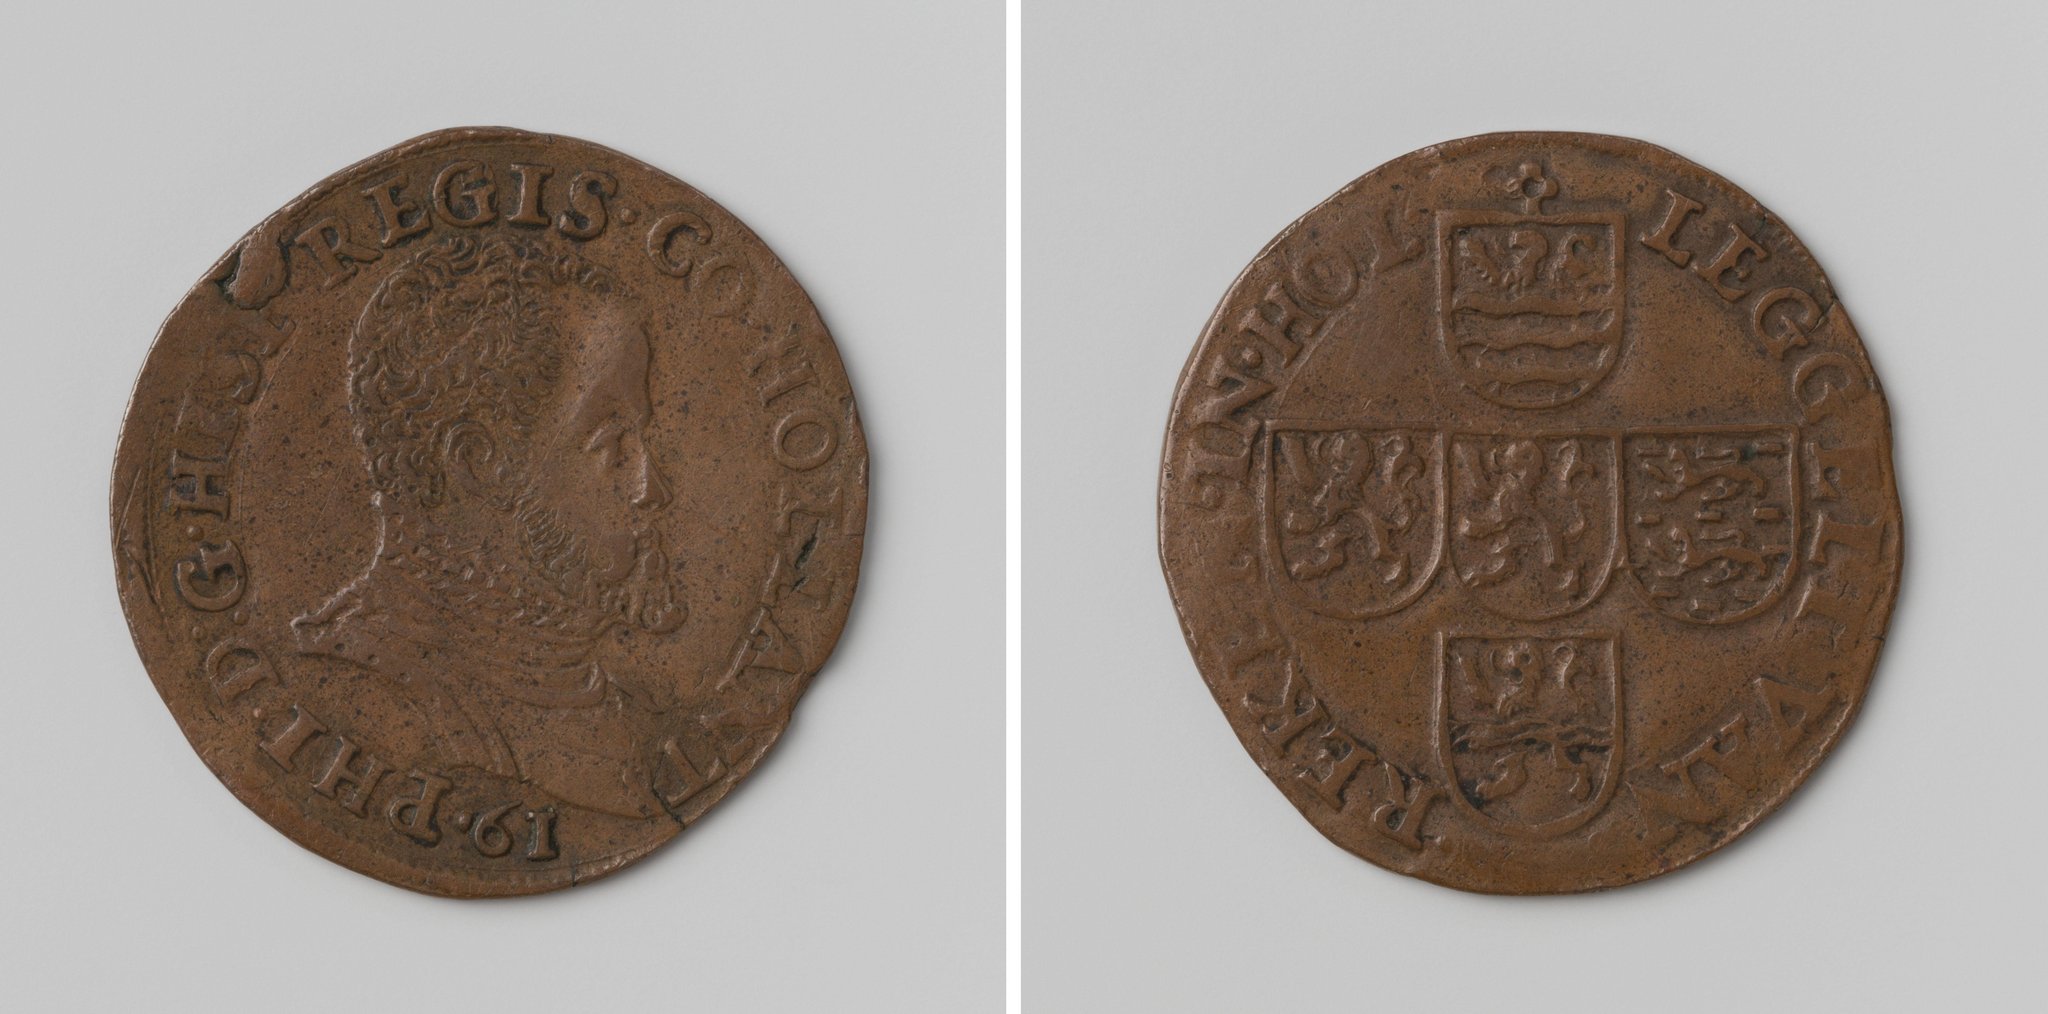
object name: jeton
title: Filips II, koning van Spanje, rekenpenning van de rekenkamer van Holland te 's-Gravenhage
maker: Anonymous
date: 1561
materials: copper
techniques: striking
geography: dordrecht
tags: philip ii of spain, the hague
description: Koperen penning. Voorzijde: borststuk man binnen omschrift. Keerzijde: vijf wapenschilden binnen omschrift